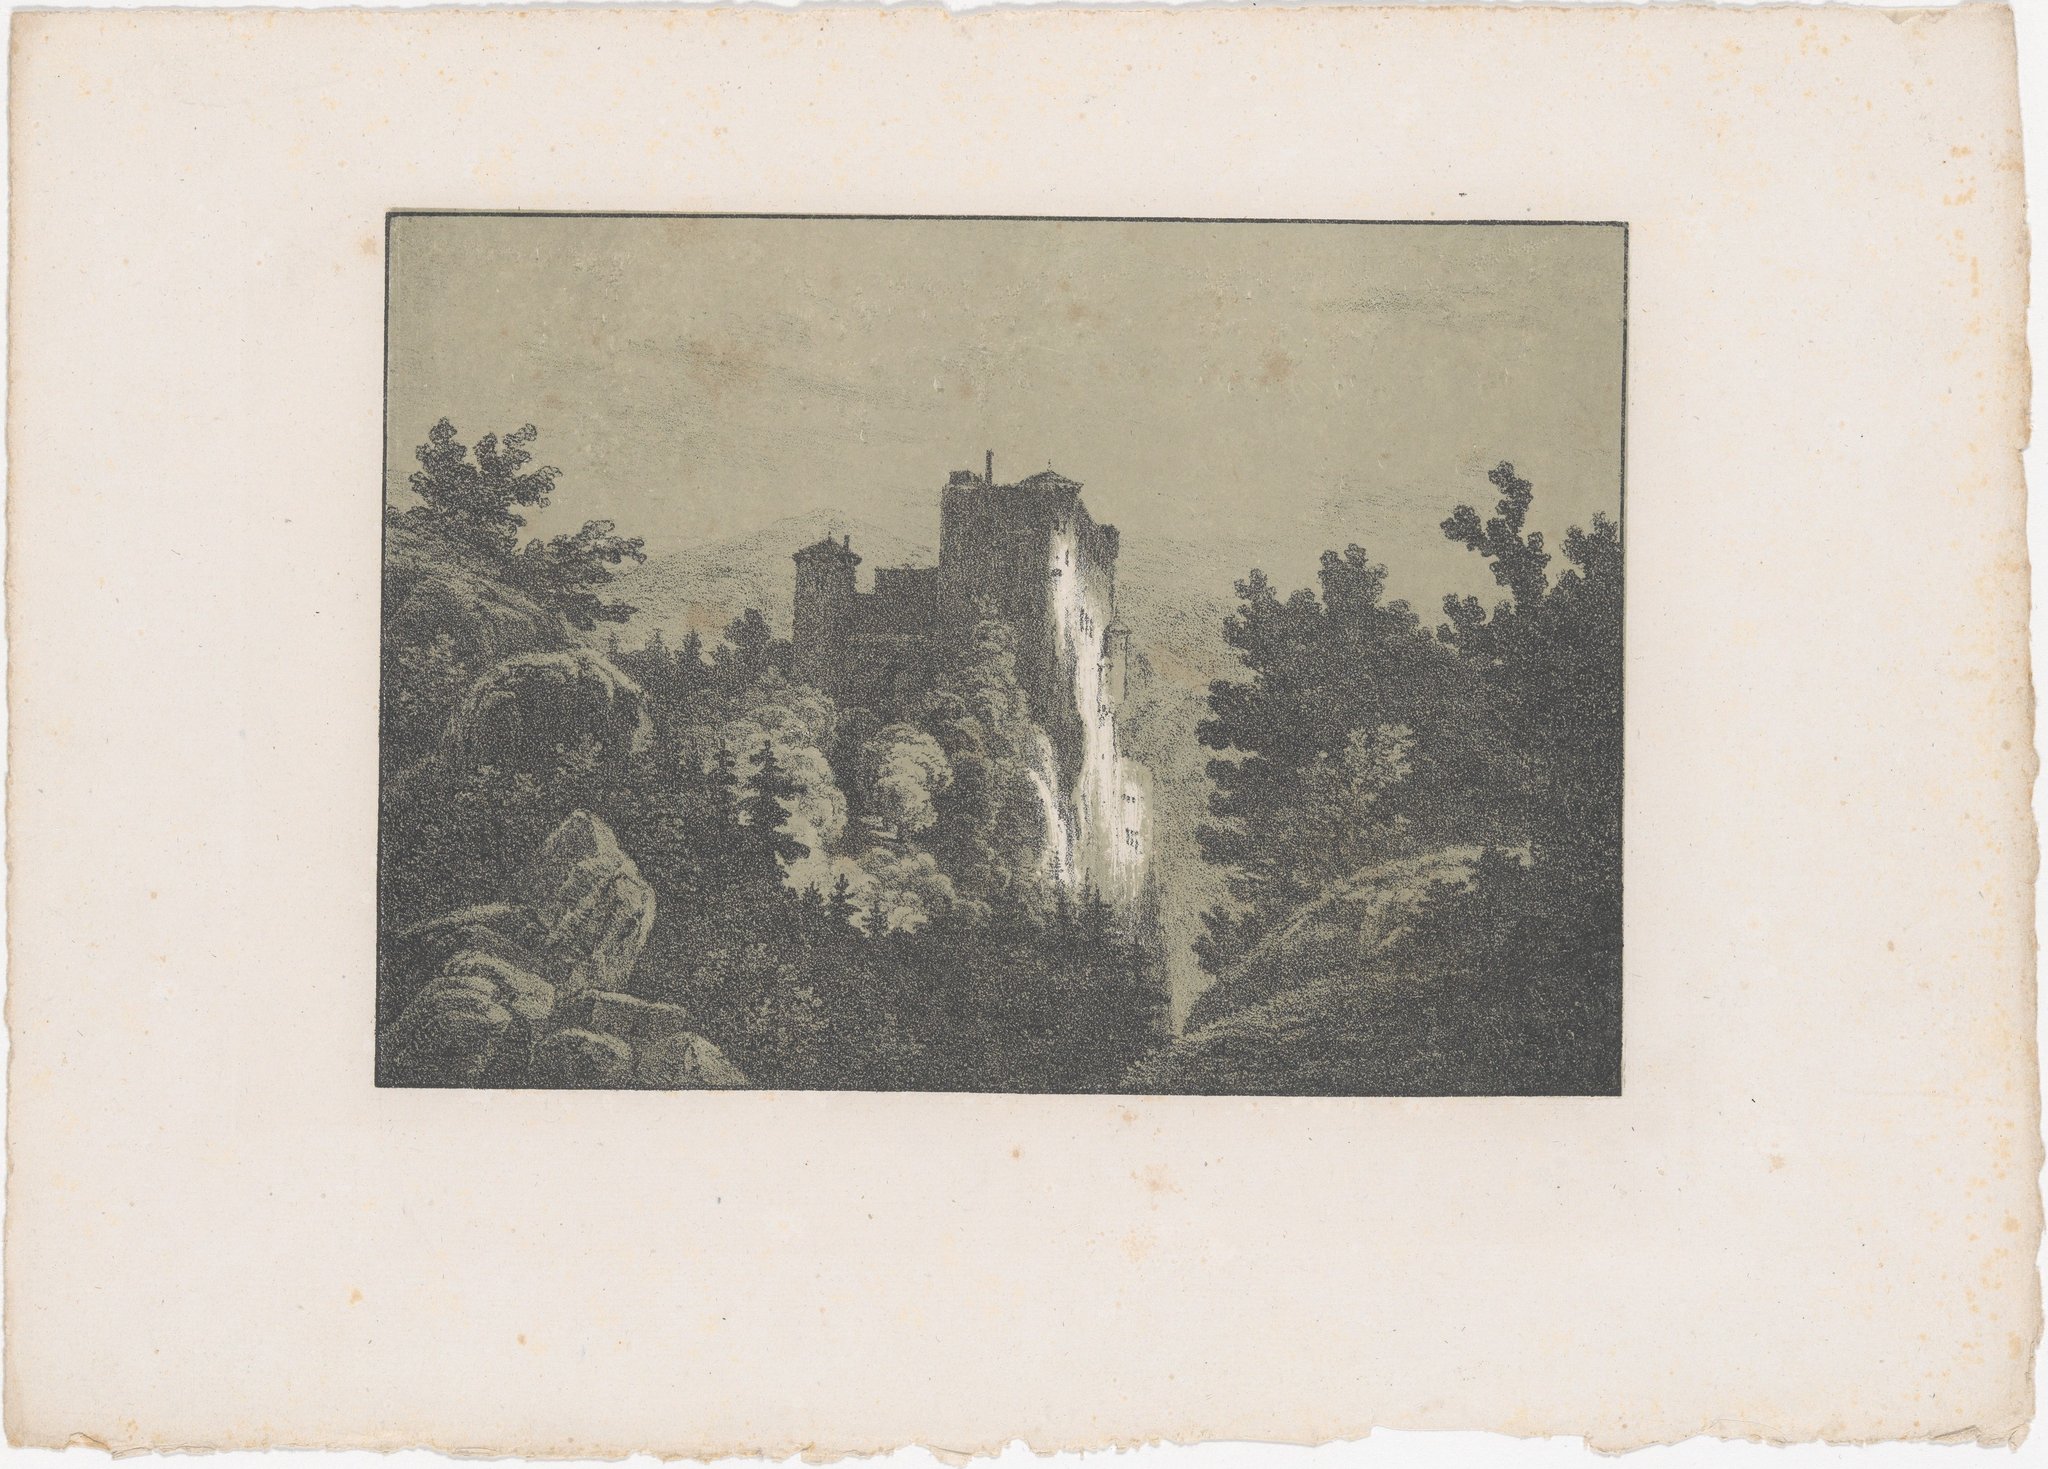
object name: print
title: Ruins of a Castle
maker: karl blechen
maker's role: artist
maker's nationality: german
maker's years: 1798-1840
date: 1827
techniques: lithograph, printing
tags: castles,ruins,trees